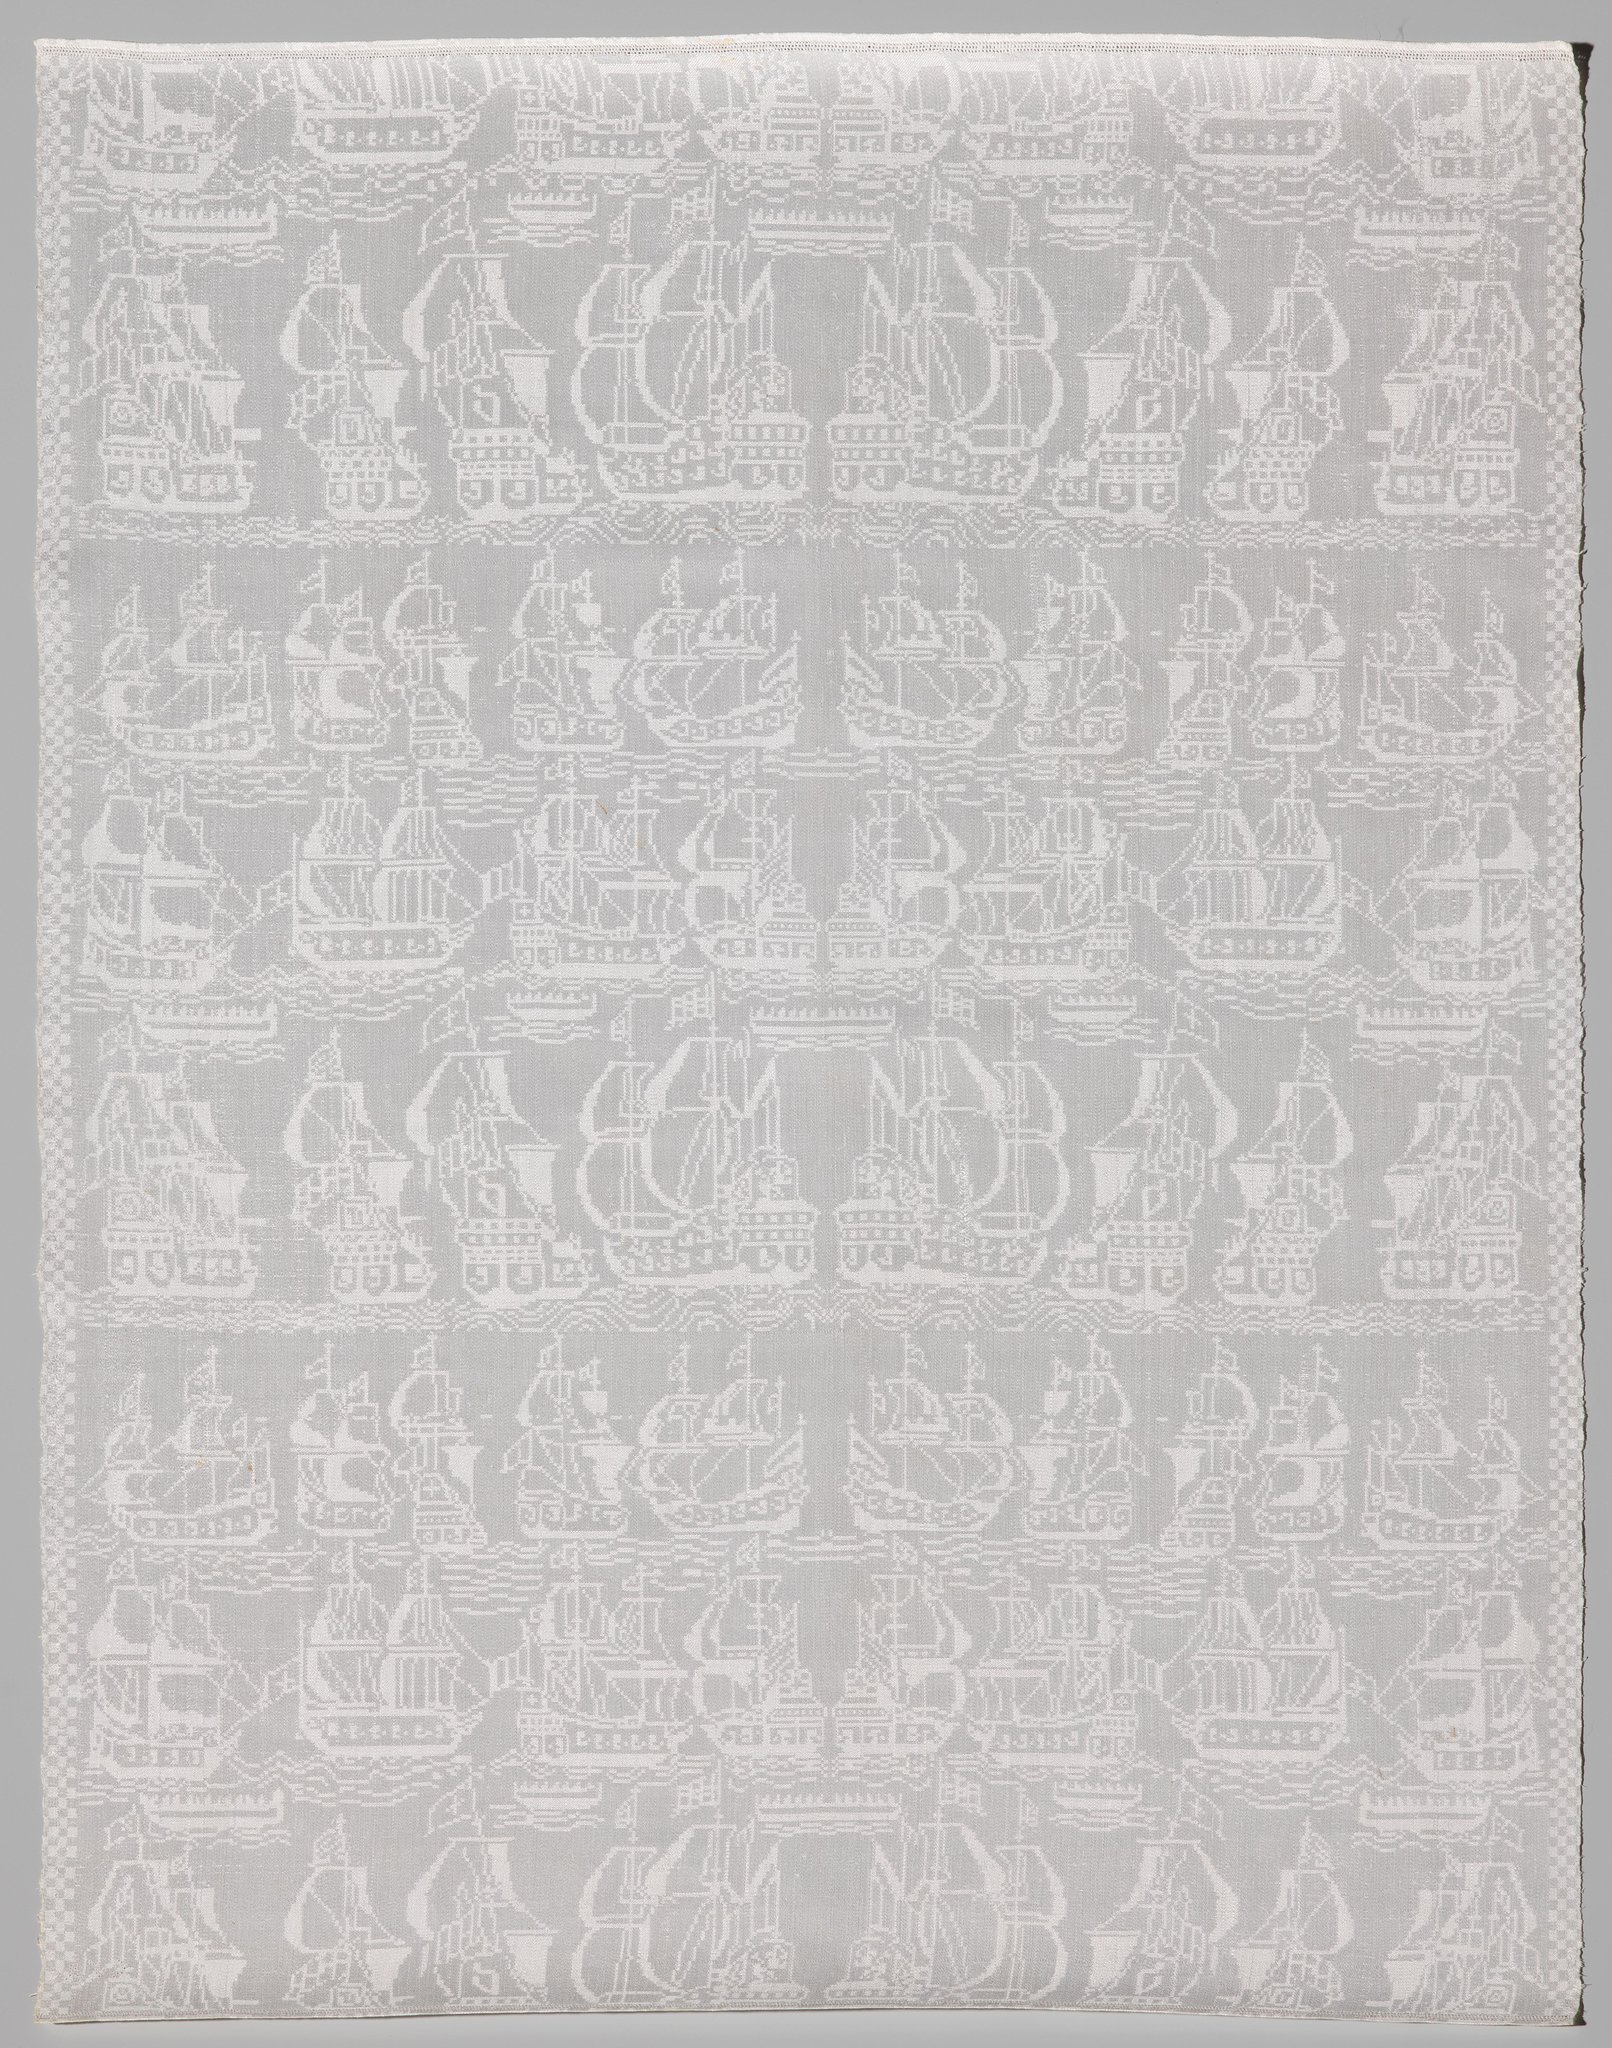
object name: napkin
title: Servet van linnendamast met zeilschepen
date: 1640-1660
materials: linen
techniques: damask, weave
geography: northern netherlands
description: Servet van linnendamast met een gespiegeld patroon van zeilschepen. De lopende randen bestaan uit een smalle geblokte rand. Het servet is gemerkt: RVG 6 WH. (Zie ook BK-16797)